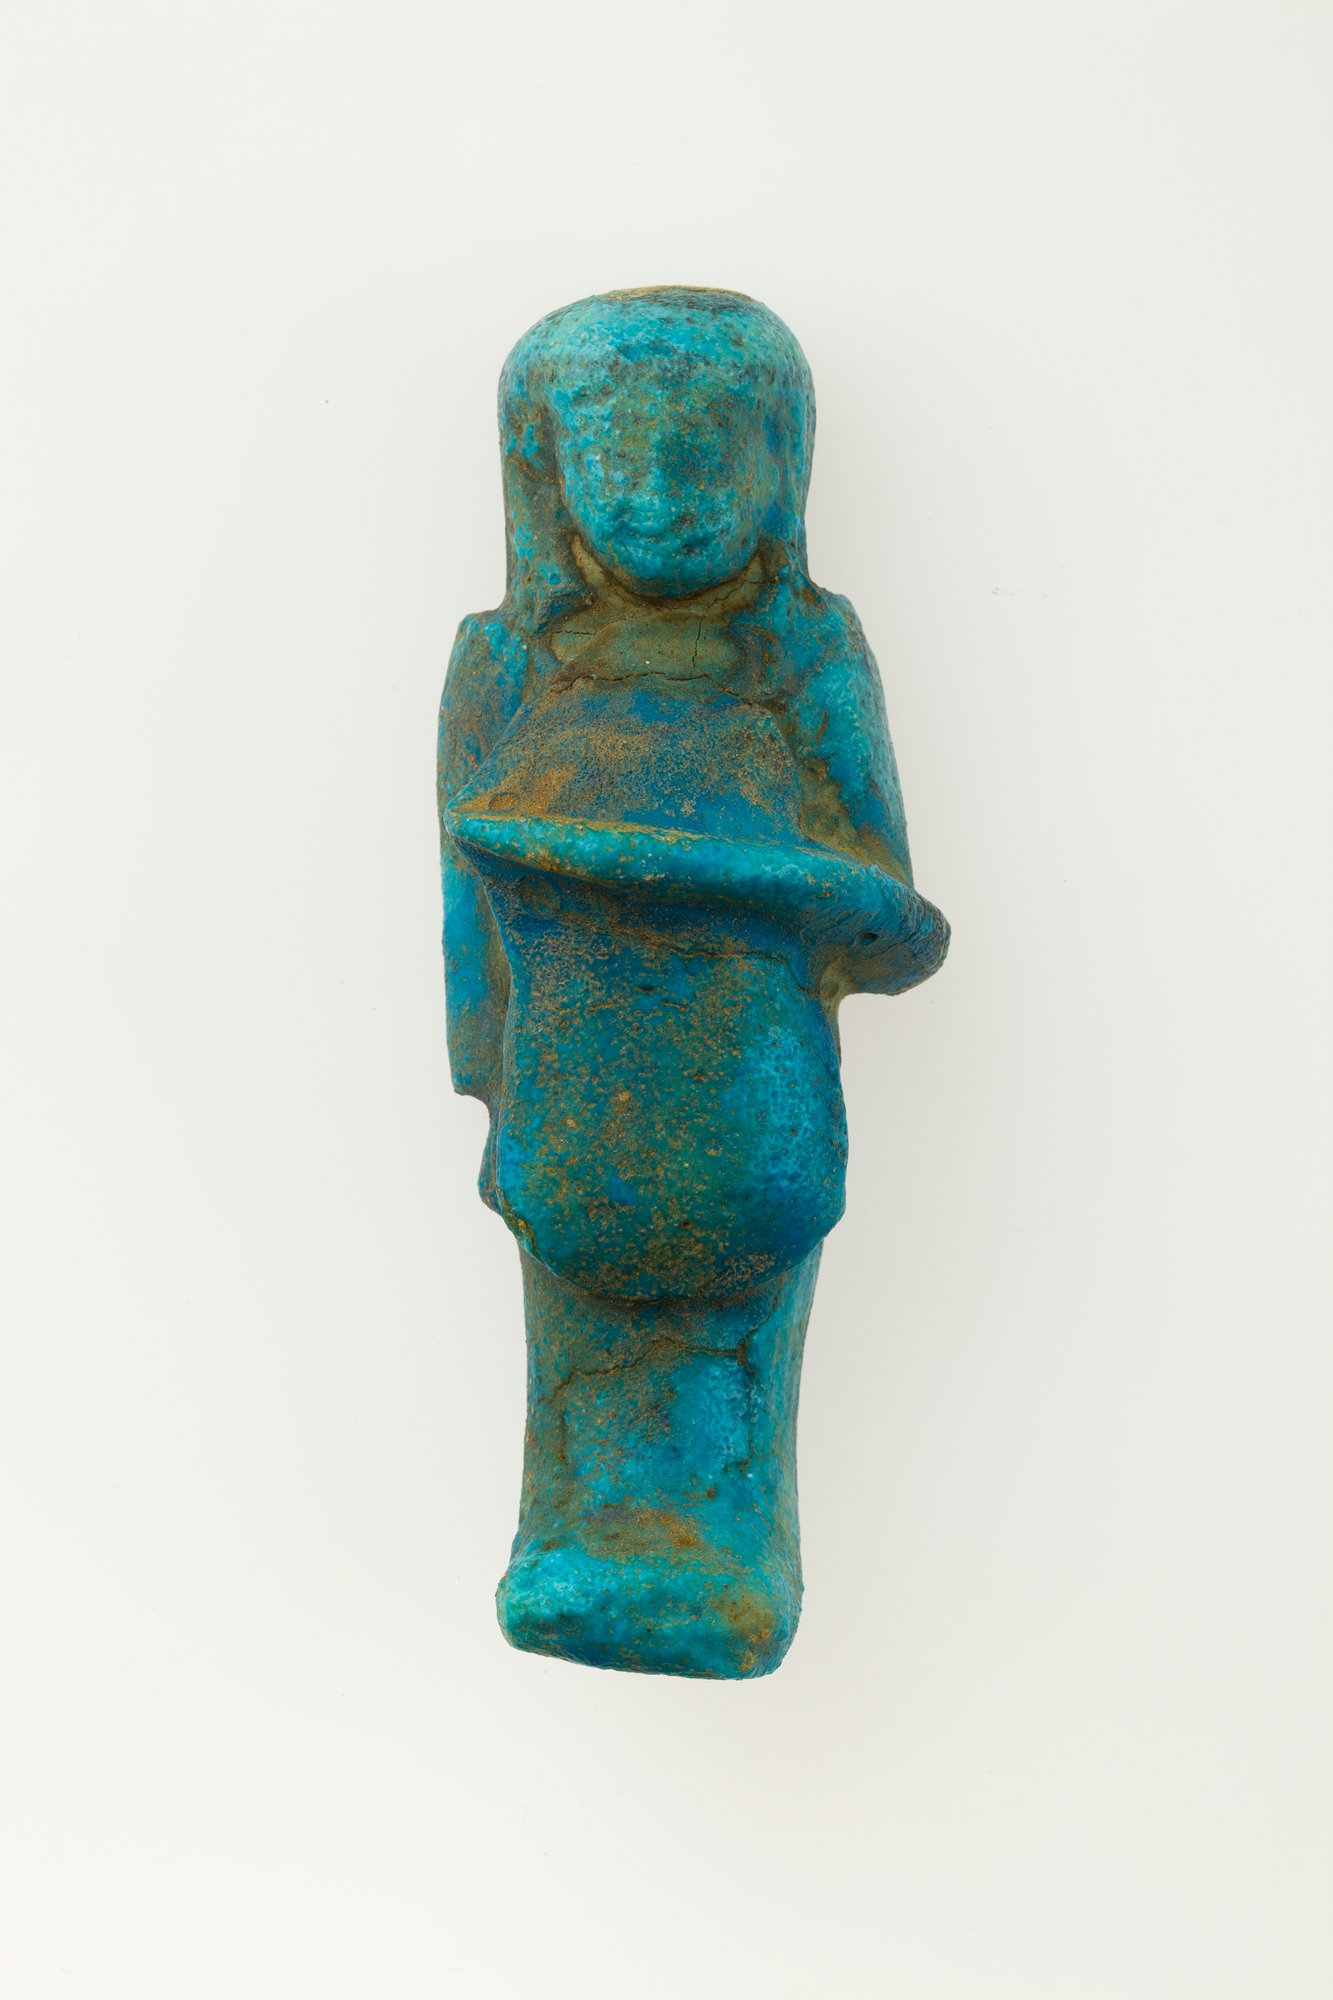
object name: shabti, henettawy c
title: Overseer Shabti of Henettawy (C), Daughter of Isetemkheb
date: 990-970 BCE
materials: faience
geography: egypt